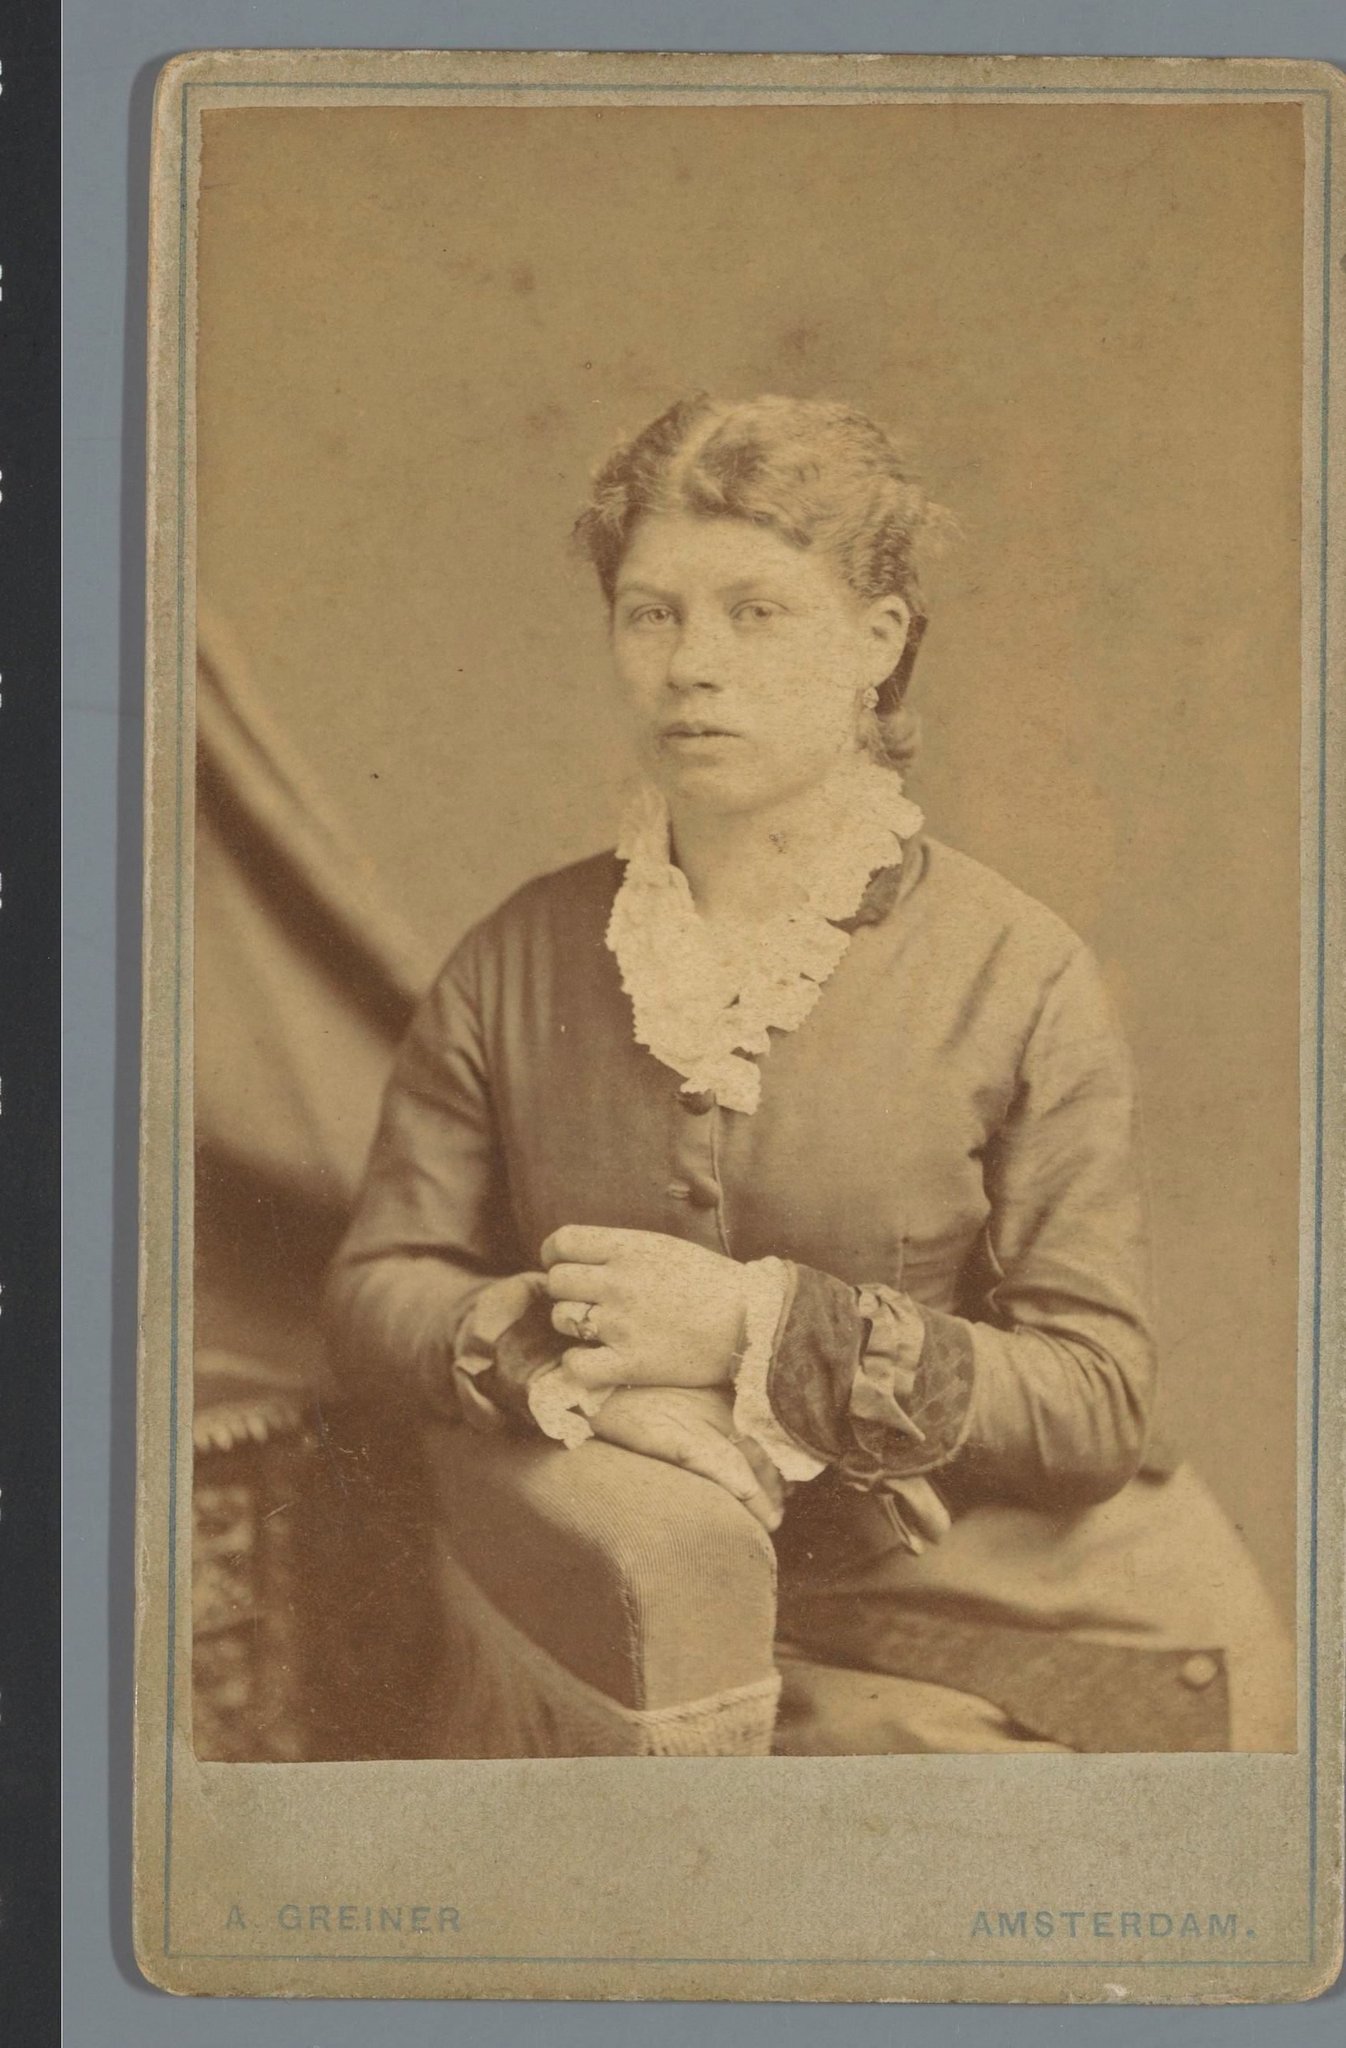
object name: carte de visite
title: Portret van een onbekende vrouw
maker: albert greiner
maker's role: fotograaf, fotostudio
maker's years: 1833-1890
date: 1880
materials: cardboard, paper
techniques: albumen print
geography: amsterdam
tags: historical persons - bb - woman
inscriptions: inscription: ‘8/12 80’, inscription: ‘6 Borsman’, inscription: ‘A. GREINER/ PHOTOGRAAF/ VAN HH:MM: DEN KONING EN/ DE KONINGIN DER NEDERLANDEN/ NIEUWENDIJK L.89./ AMSTERDAM.’